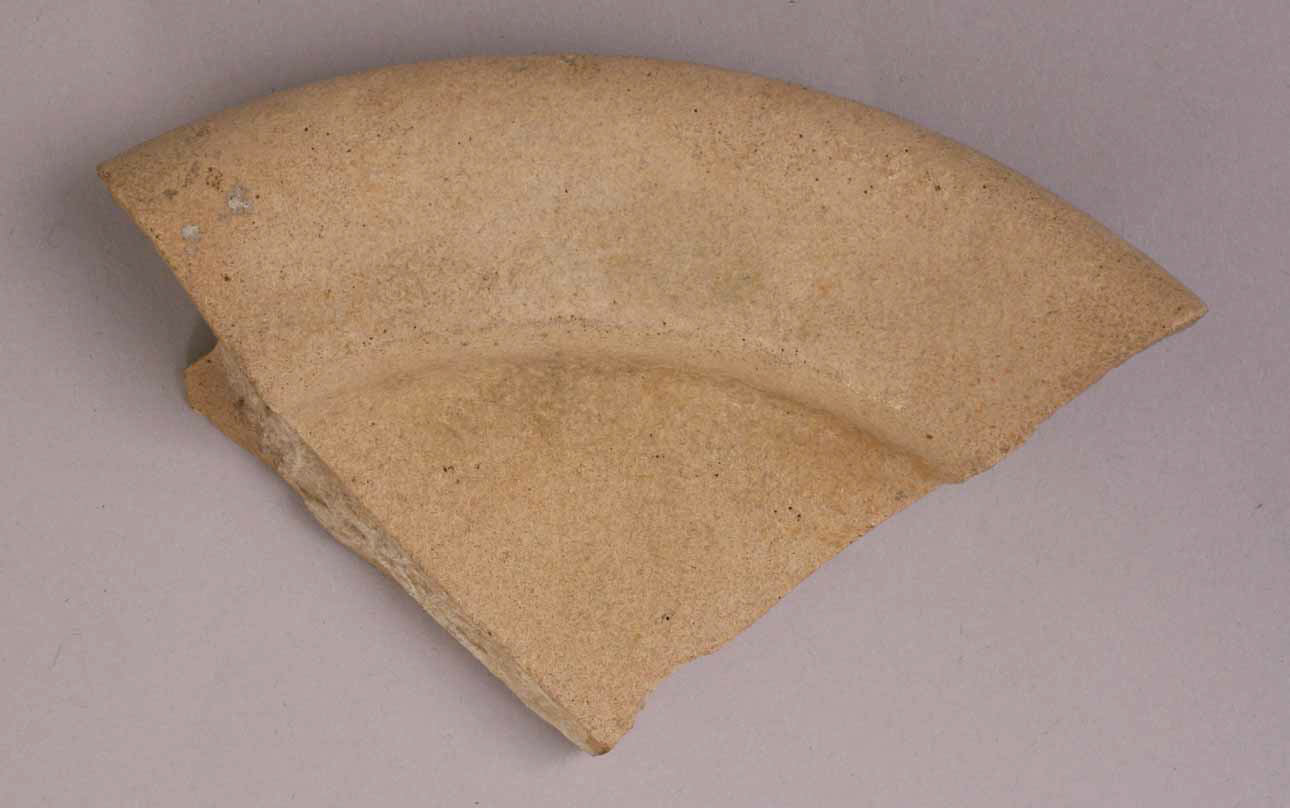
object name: fragment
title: Ceramic Fragment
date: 701-900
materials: earthenware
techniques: glazing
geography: iraq